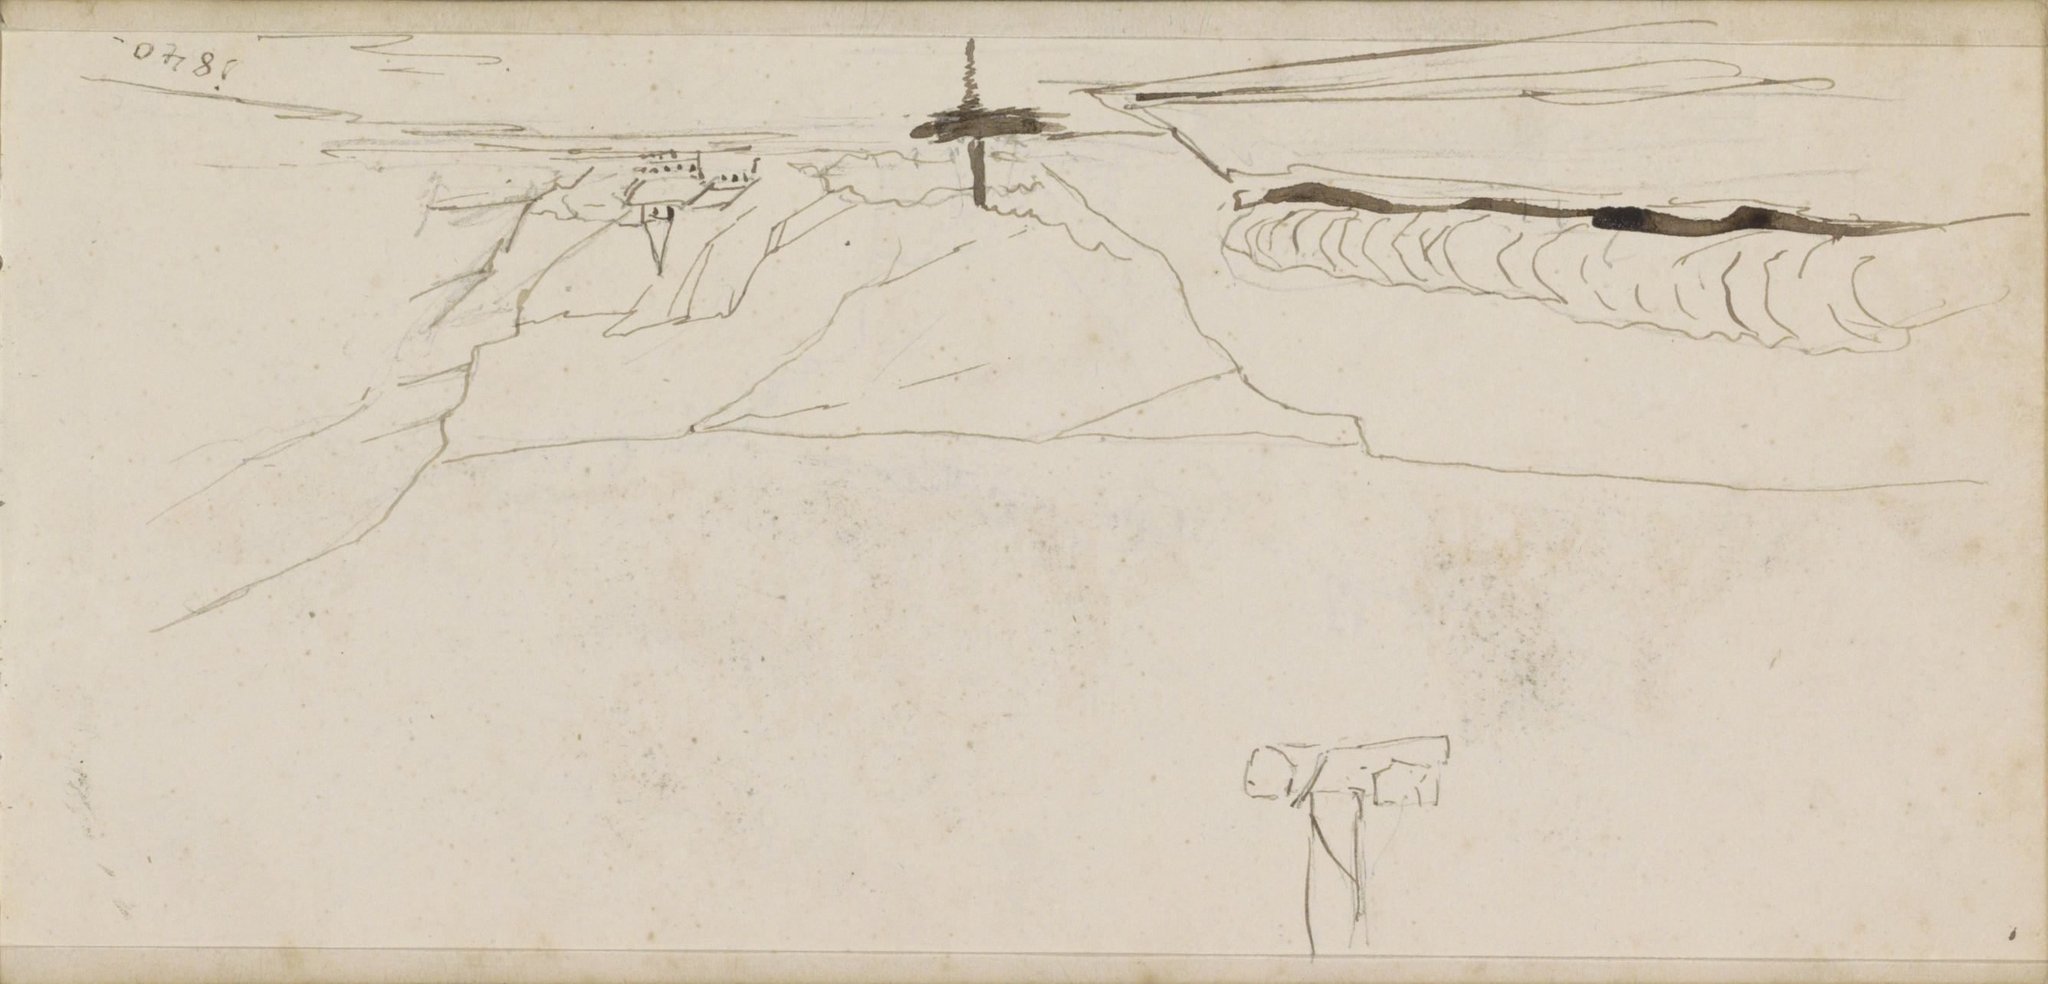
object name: sketchbook leaf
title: Bergen aan een meer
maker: johannes tavenraat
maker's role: draughtsman, painter, print maker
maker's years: 1809-1881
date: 1840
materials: ink, paper, pencil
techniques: pen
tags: city-view, and landscape with man-made constructions, sailing-ship, sailing-boat, landscapes with waters, waterscapes, seascapes (in the temperate zone), church (exterior), mountains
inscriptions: date: ‘1840.’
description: Tegen de berg aan ligt een kerk. Blad 32 recto uit een schetsboek met 63 bladen.